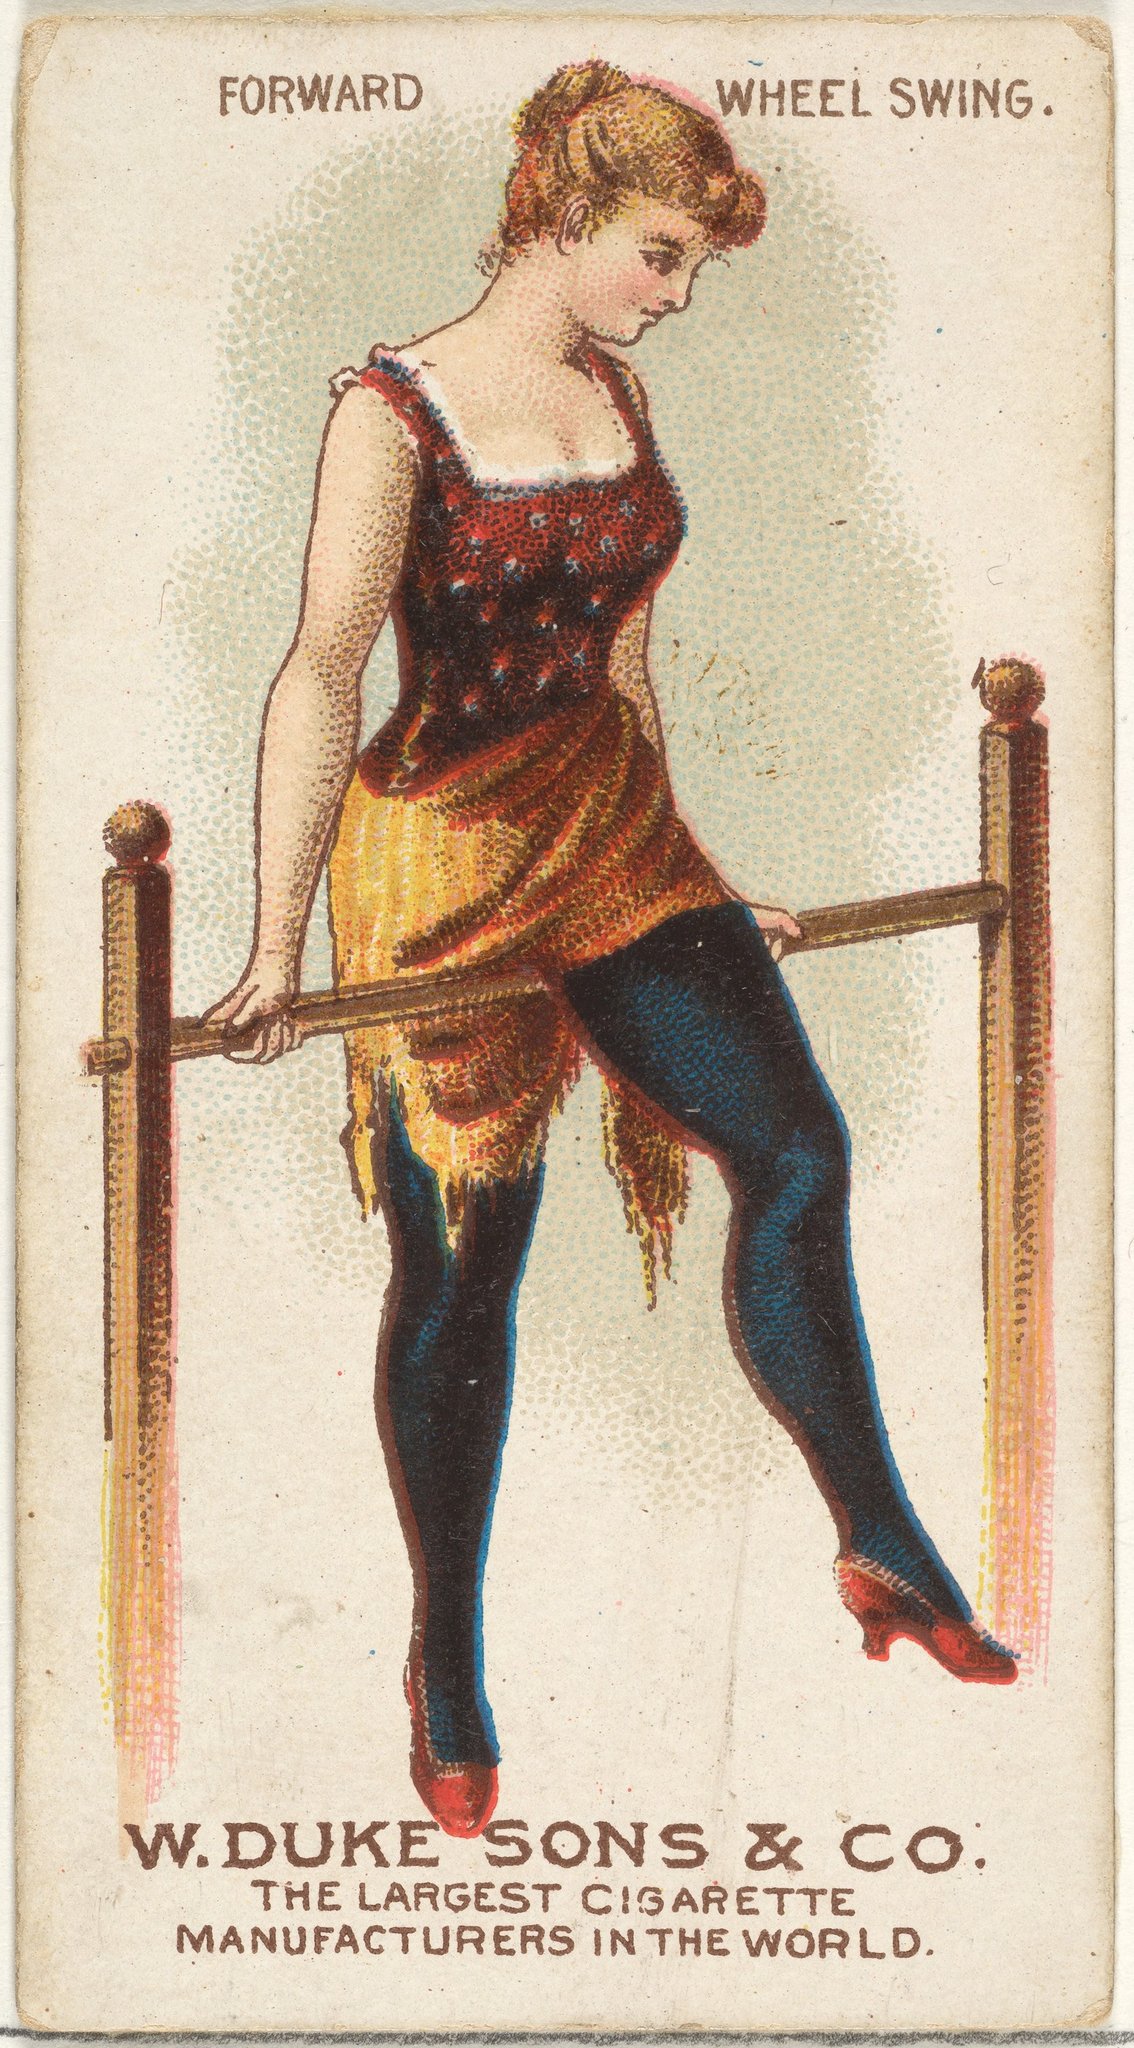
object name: print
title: Forward Wheel Swing, from the Gymnastic Exercises series (N77) for Duke brand cigarettes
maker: w. duke, sons & co.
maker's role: publisher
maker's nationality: american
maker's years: 1870-1920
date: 1887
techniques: color lithograph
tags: women,athletes